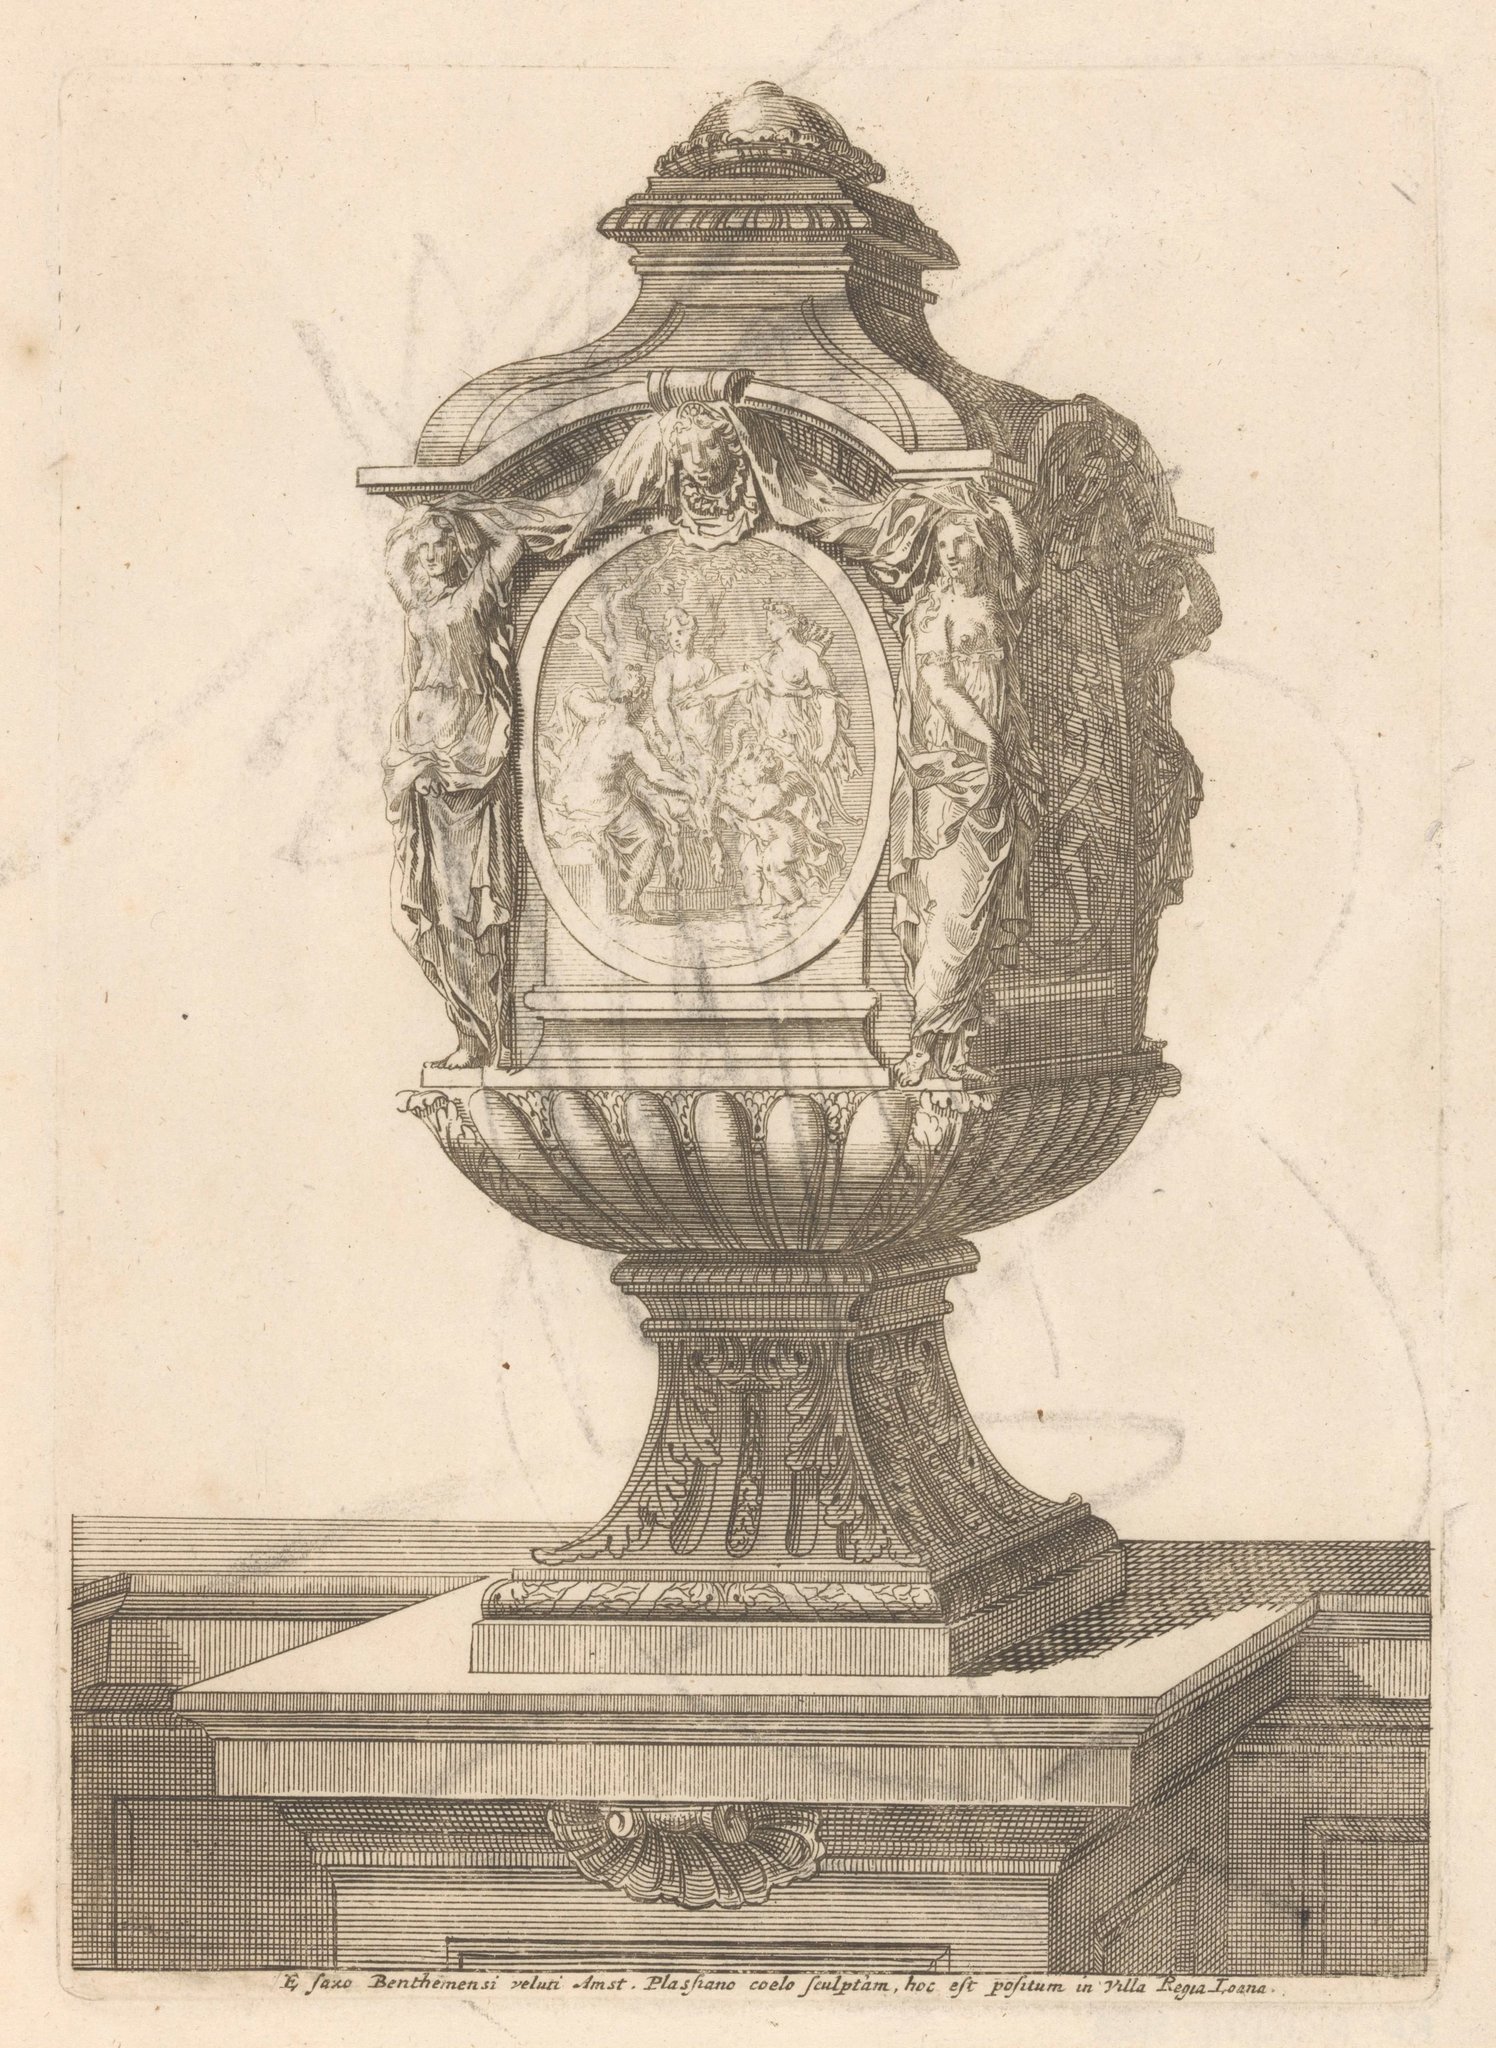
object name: ornament print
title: Tuinvazen van Paleis Het Loo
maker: Anonymous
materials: paper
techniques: etching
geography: netherlands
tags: (story of) diana (artemis), garden vase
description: Vaas op een vierkante voet met bas-reliëf met vier kariatiden op de hoeken van de vaas. Daartussen ovale bas-reliëfs, de voorste met Diana en Cupido. In de ondermarge een Latijnse tekst.